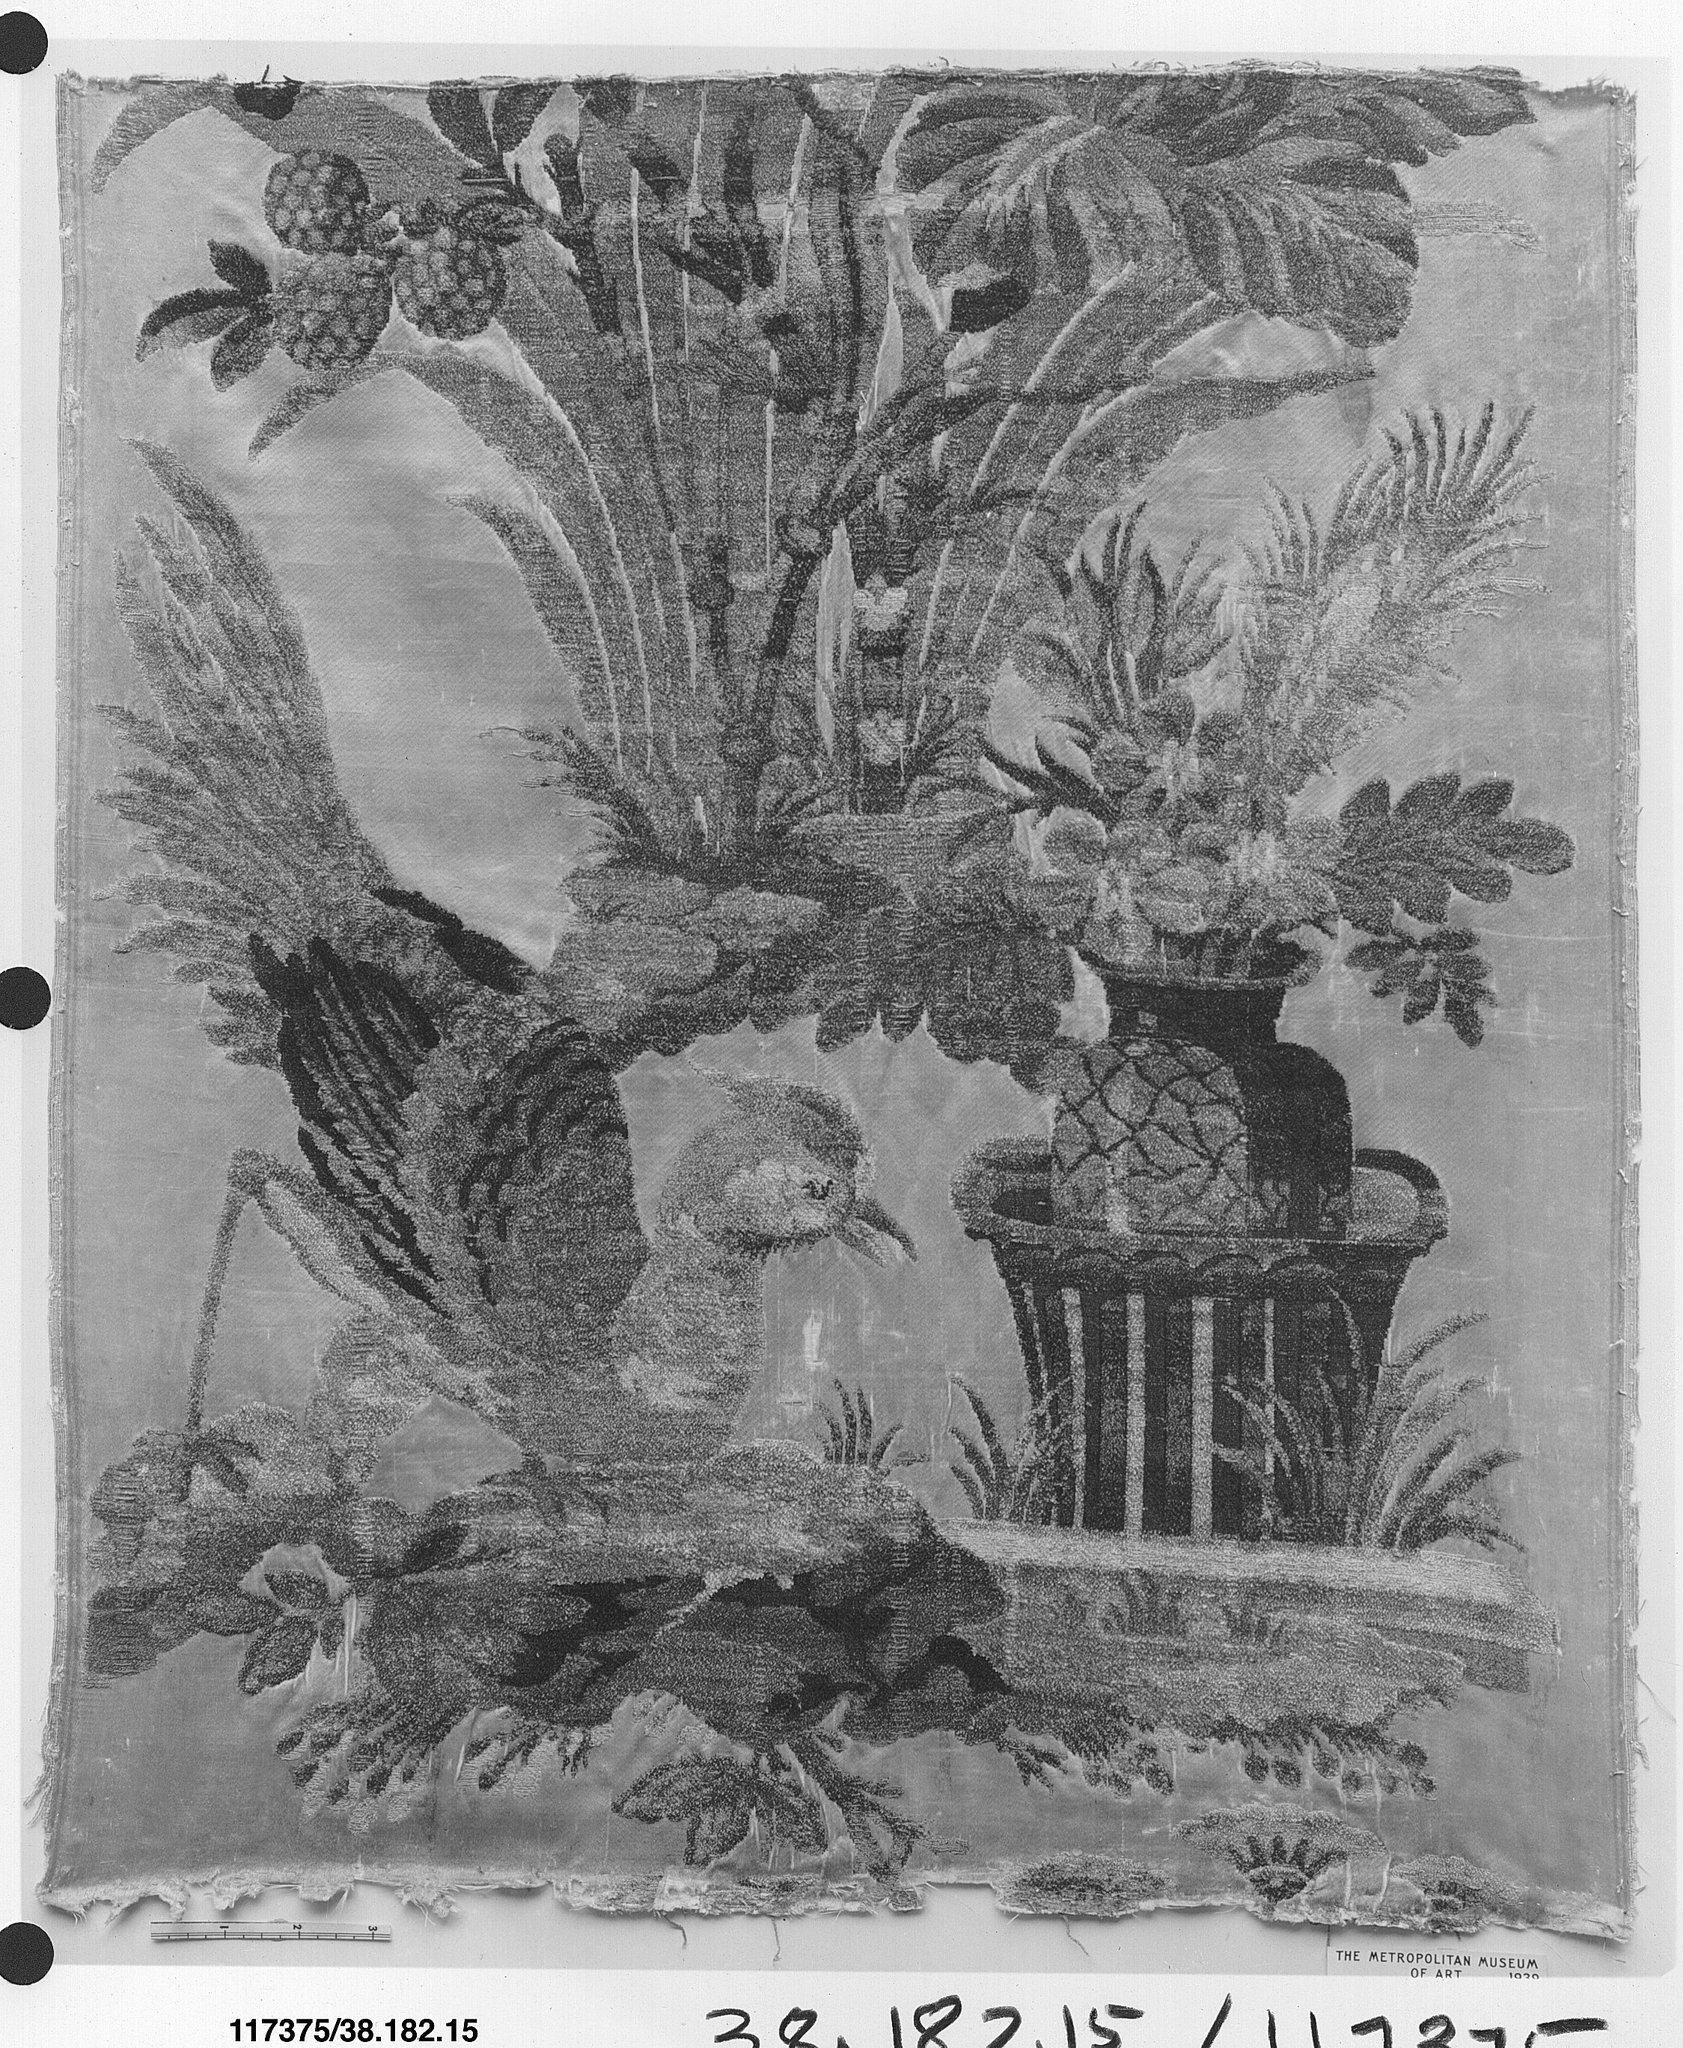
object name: piece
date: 1701-1800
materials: silk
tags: birds,flowers,leaves